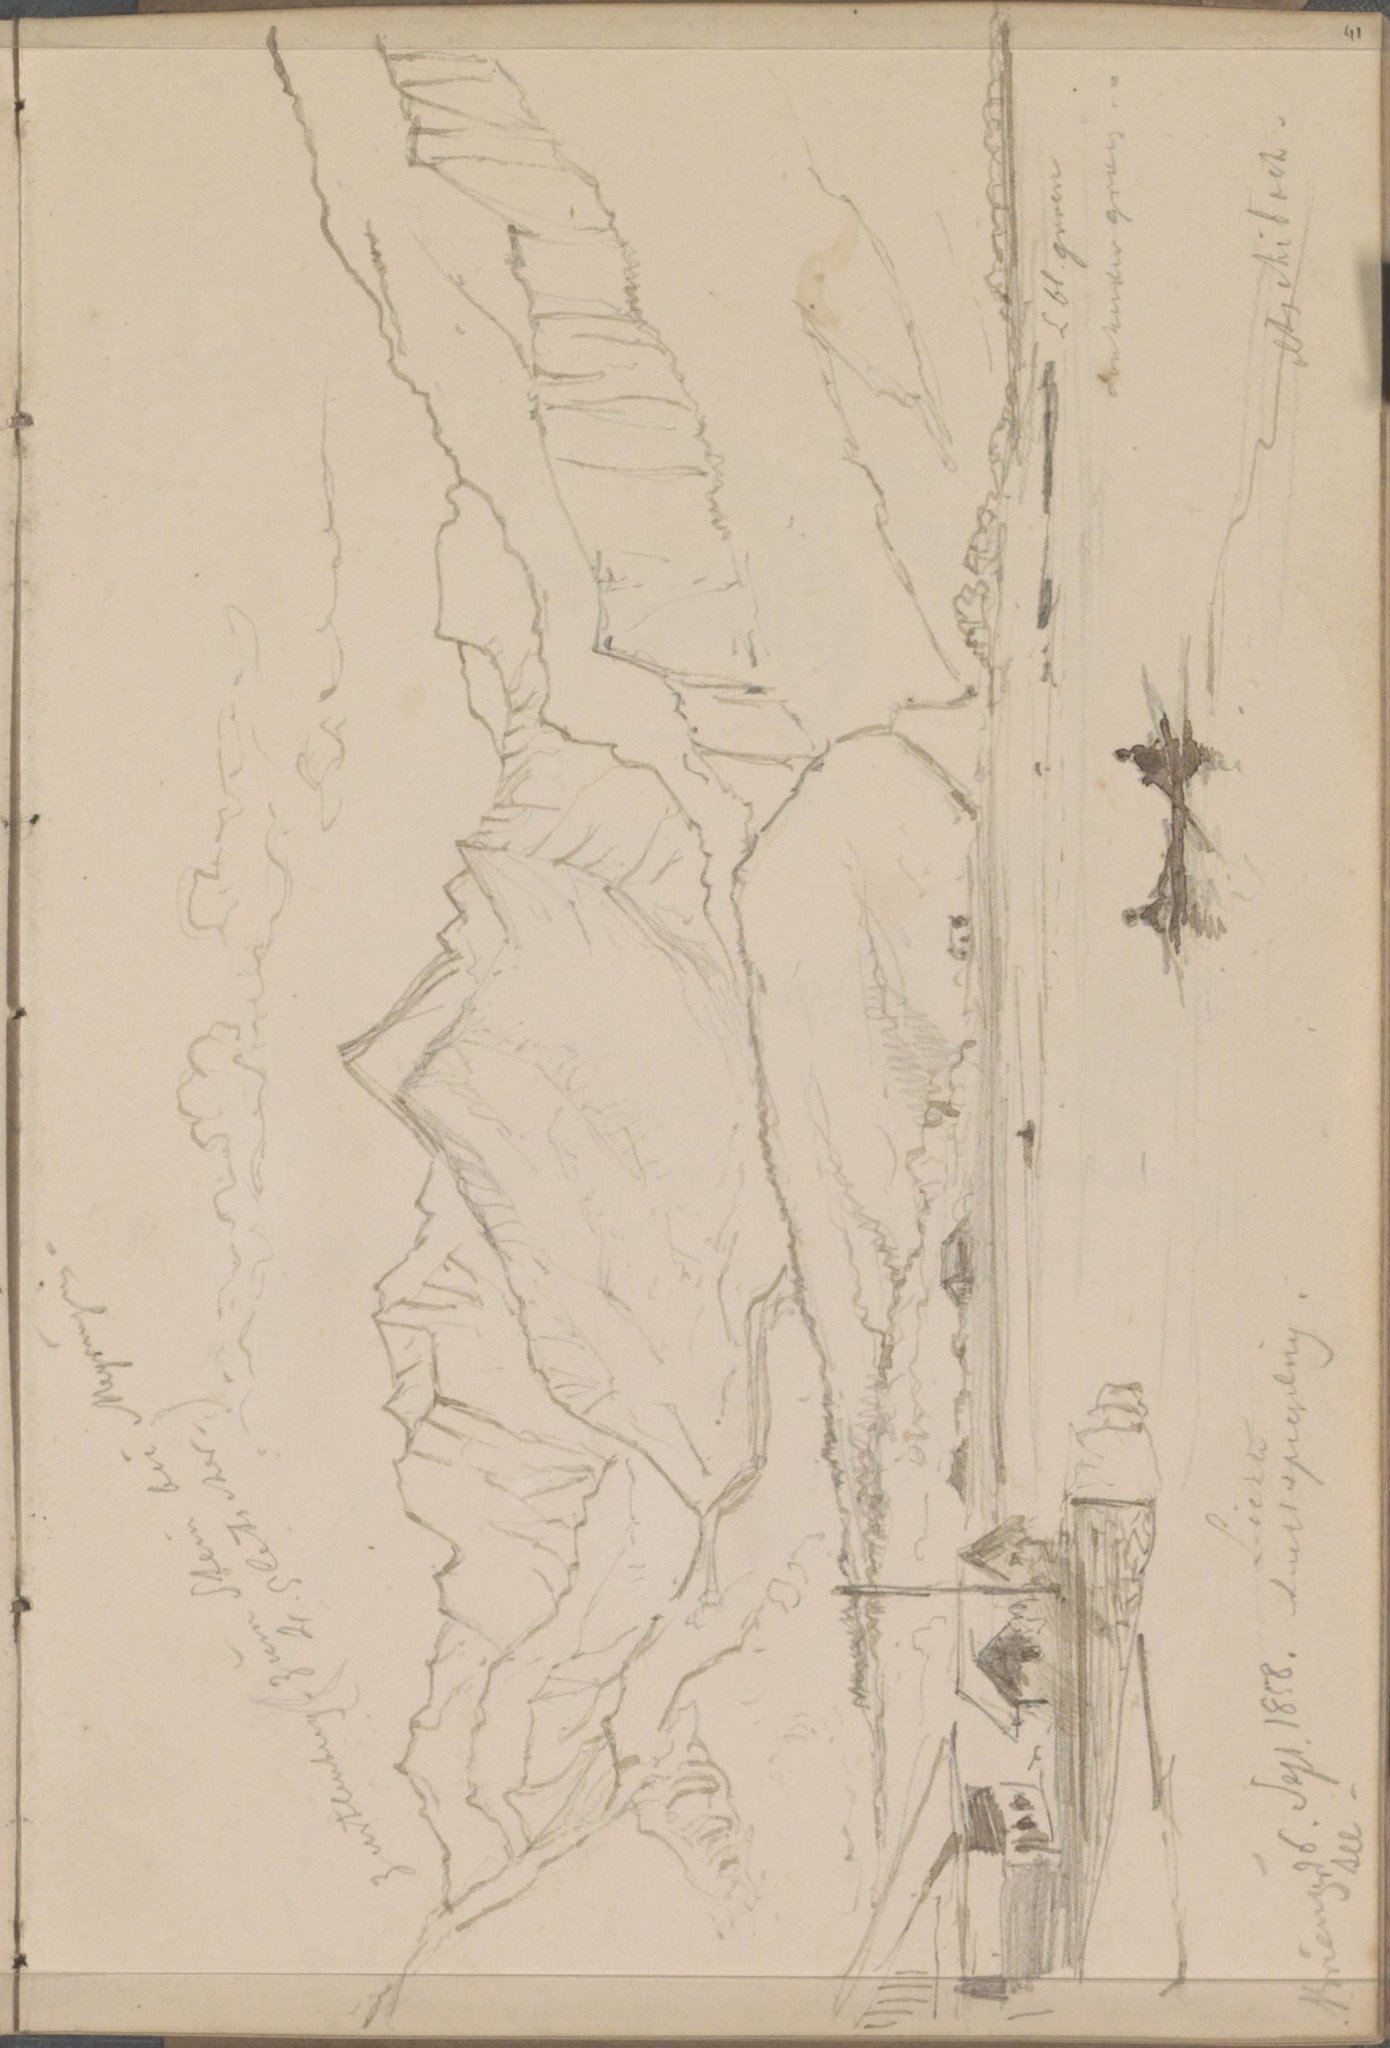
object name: sketchbook leaf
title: Meer van Brienz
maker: johannes tavenraat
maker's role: draughtsman, painter, print maker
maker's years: 1809-1881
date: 1809-1858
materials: ink, paper, pencil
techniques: pen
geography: alps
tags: city-view, and landscape with man-made constructions, rowing-boat, canoe, etc., lake, mountain-range, snow peaks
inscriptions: date and inscription: ‘zustenberg (zum Stein bei Ney[...]/ zr Gletscher)/ Brienzer 16 Sept 1858/ see’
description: Aan het meer enkele huizen. Op de achtergrond de Alpen. Blad 41 recto uit een schetsboek met 47 bladen.